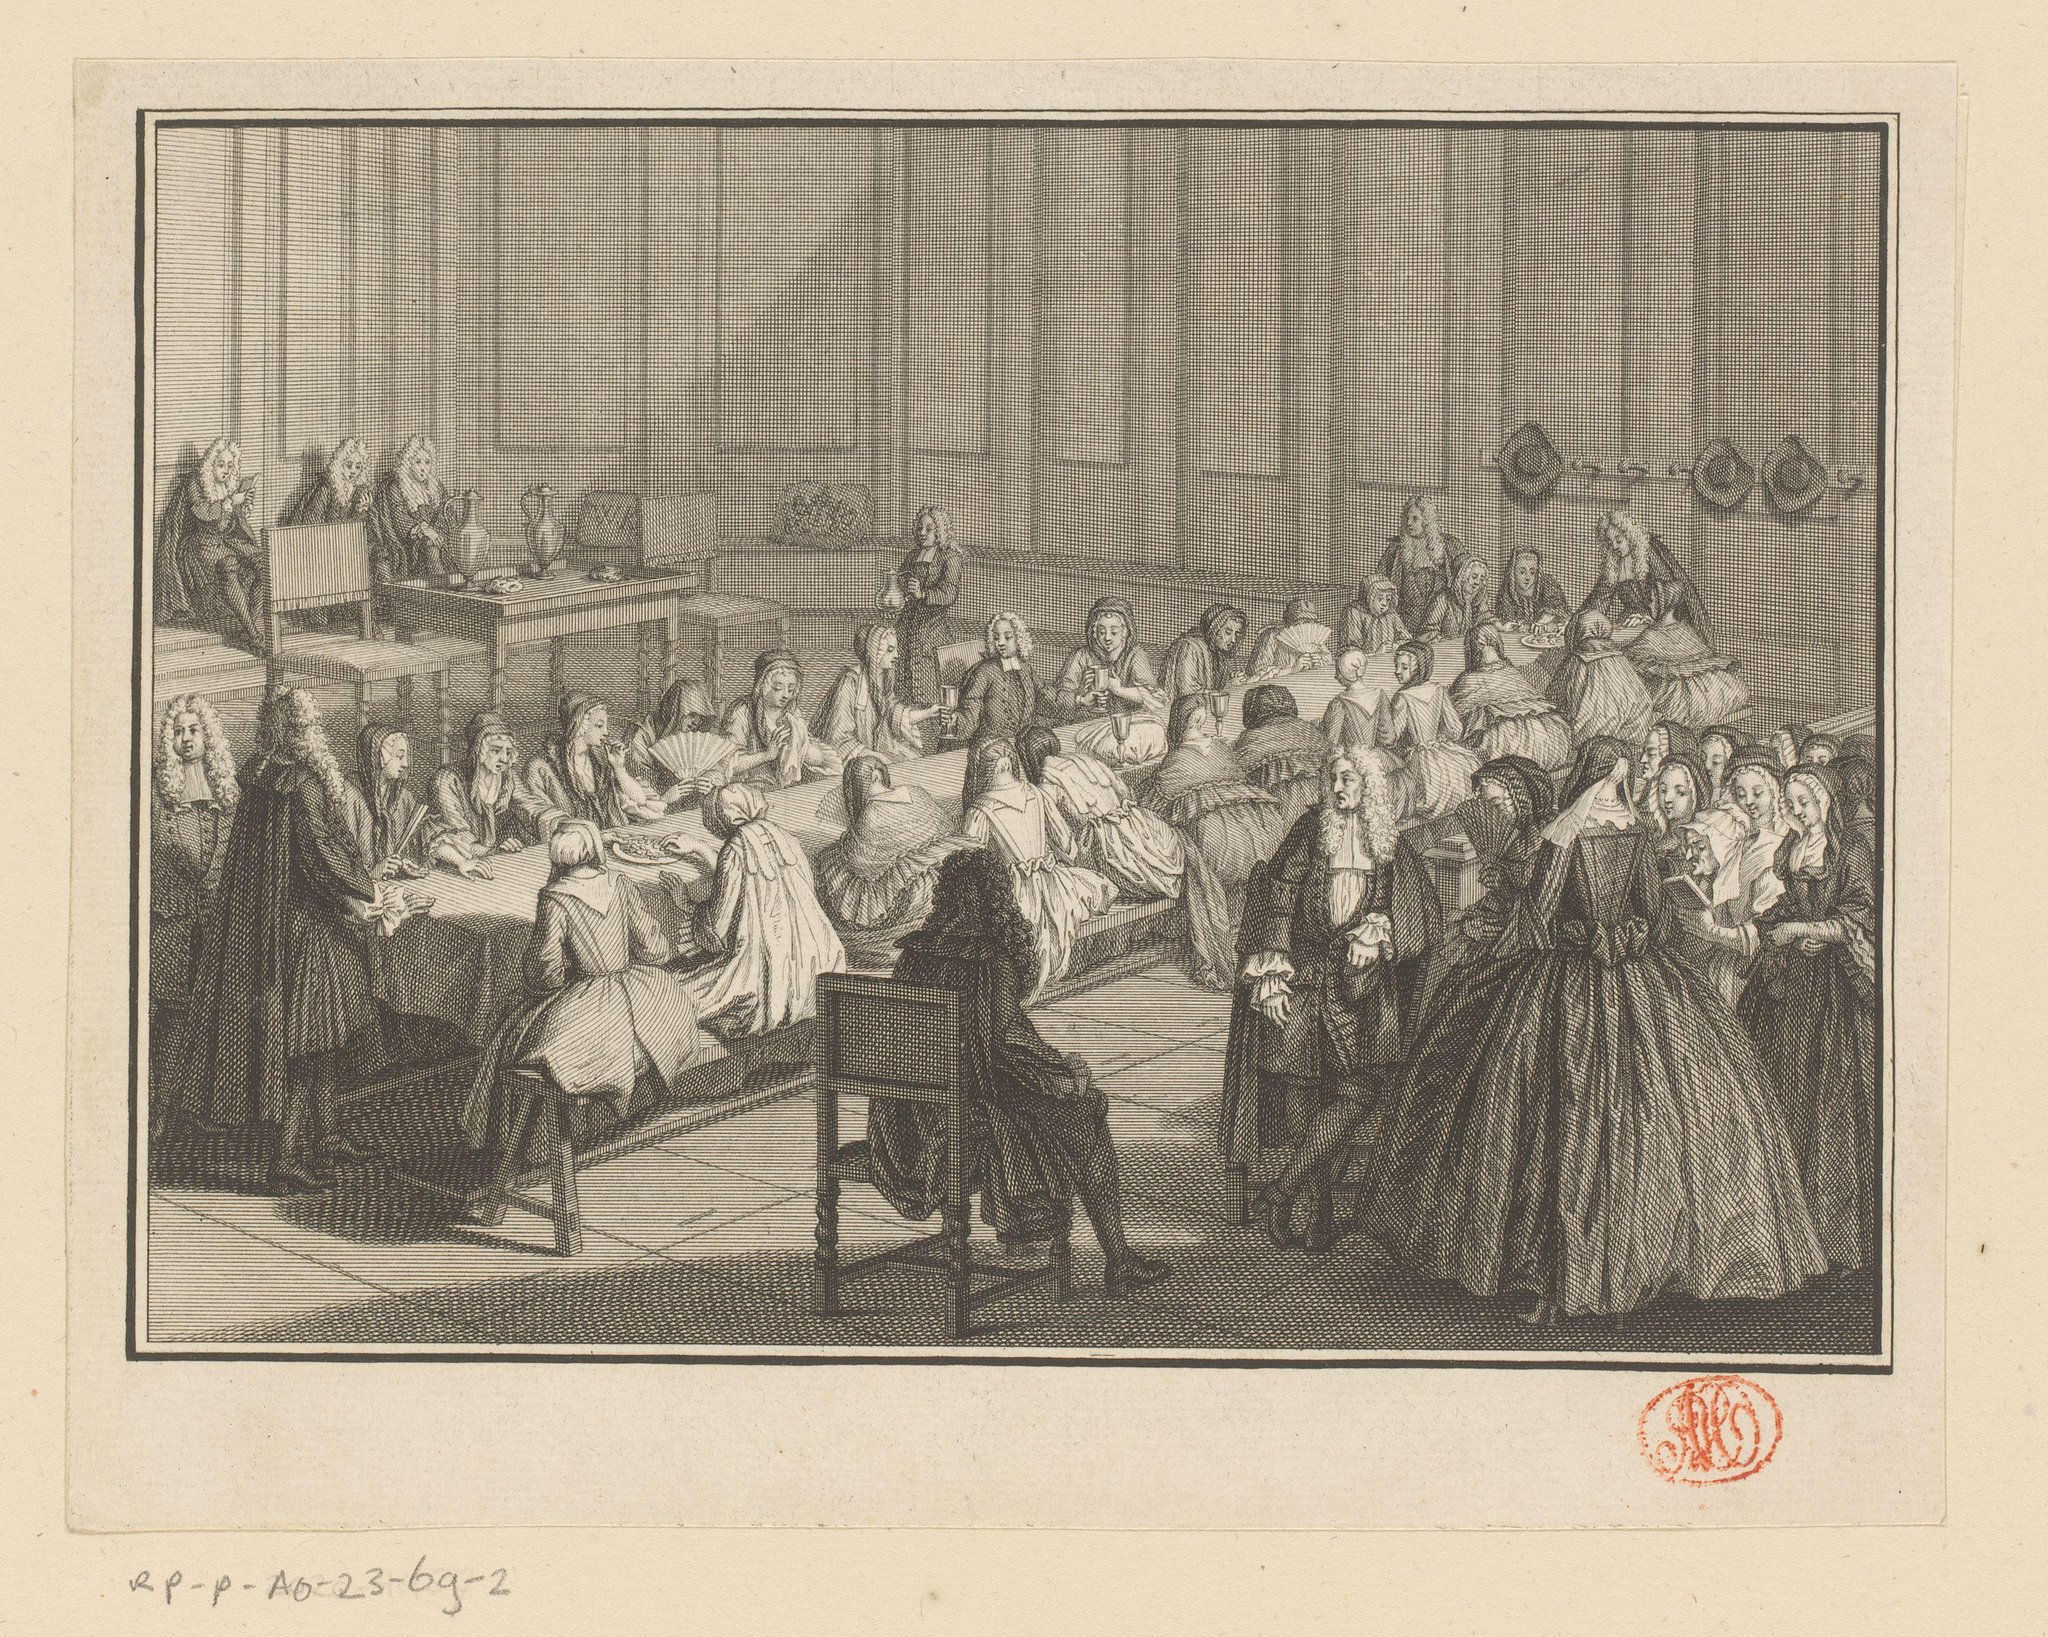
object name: print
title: Avondmaal bij de Gereformeerden te Amsterdam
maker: bernard picart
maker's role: draughtsman, print maker, publisher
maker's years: 1673-1733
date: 1732-1736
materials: paper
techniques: engraving, etching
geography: amsterdam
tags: holy communion ~ protestant service, amsterdam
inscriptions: collector's mark: Lugt 195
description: Andere staat gebruikt in: Picart, Bernard. Ceremonies et coutumes religieuses de tous les peuples du monde (...). Amsterdam: Jean Frederic Bernard, 1733, dl. 3. En in: Naaukeurige beschryving der uitwendige godtsdienst-plichten (...). Amsterdam: Hermanus Uytwerf et al., 1736, dl. 5. Prent mogelijk ook gebruikt in andere publicaties.